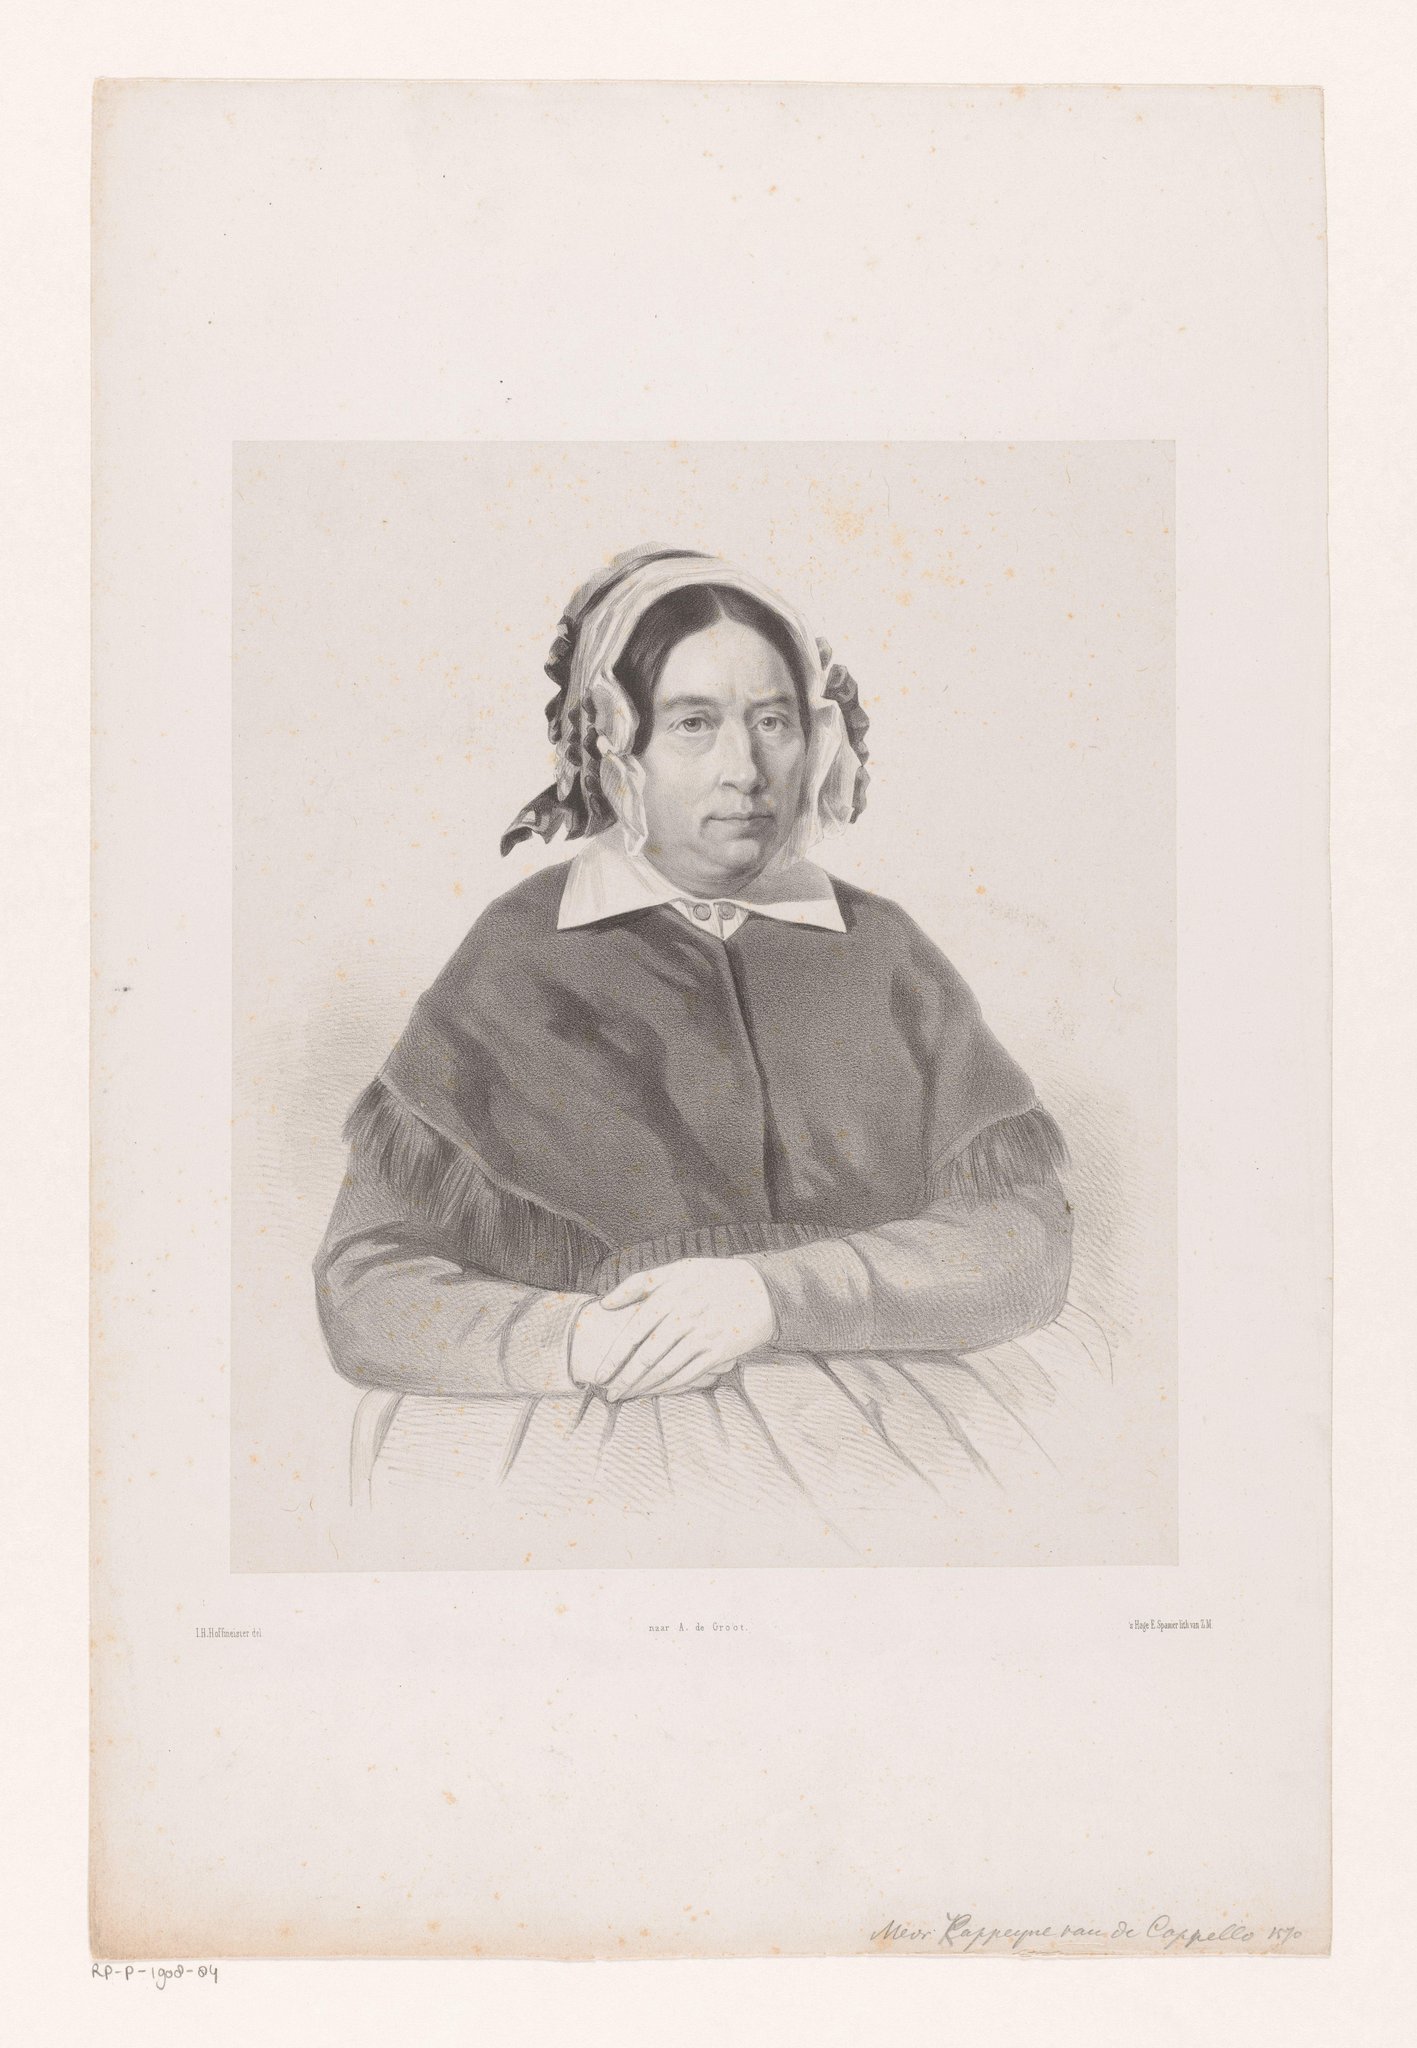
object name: print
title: Portret van een onbekende vrouw, mogelijk mevrouw Kappeyne van de Coppello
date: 1851-1883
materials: paper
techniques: lithograph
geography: netherlands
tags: historical persons - bb - woman (+ half-length portrait)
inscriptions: collector's mark: Lugt 2228